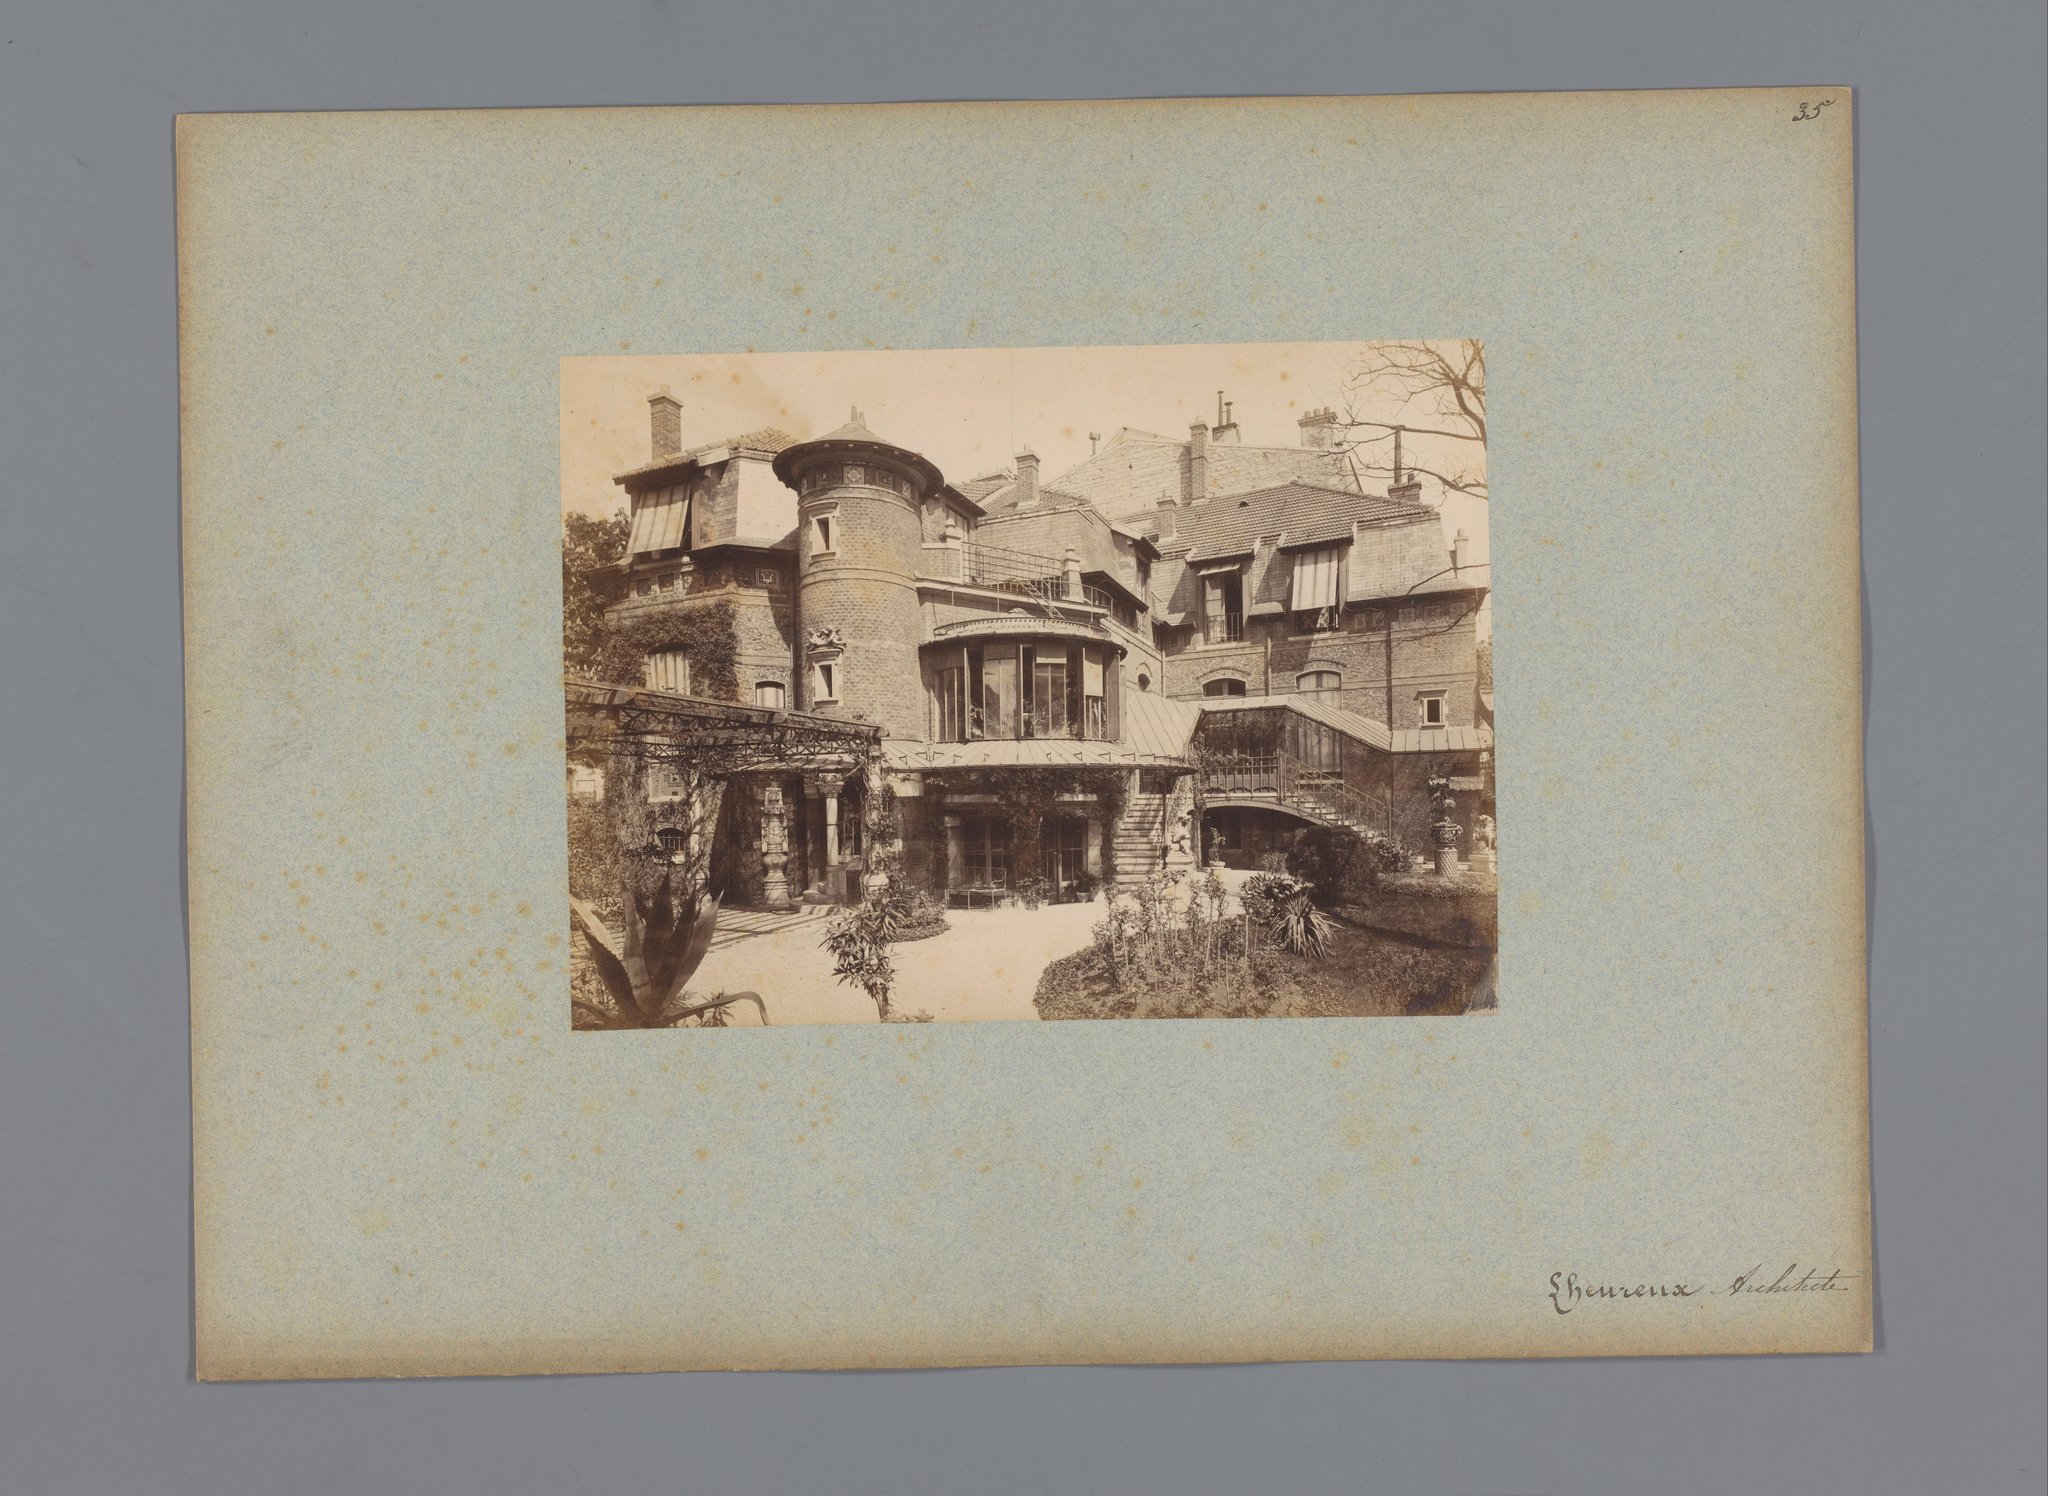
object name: photograph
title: Villa in Parijs, ontworpen door Louis-Ernest Lheureux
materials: photographic support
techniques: albumen print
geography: paris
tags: detached house in city, paris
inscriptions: number: ‘35’, name: ‘Lheureux Architecte’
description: Deze foto maakt deel uit van een omslag met 35 foto's en een titelblad.